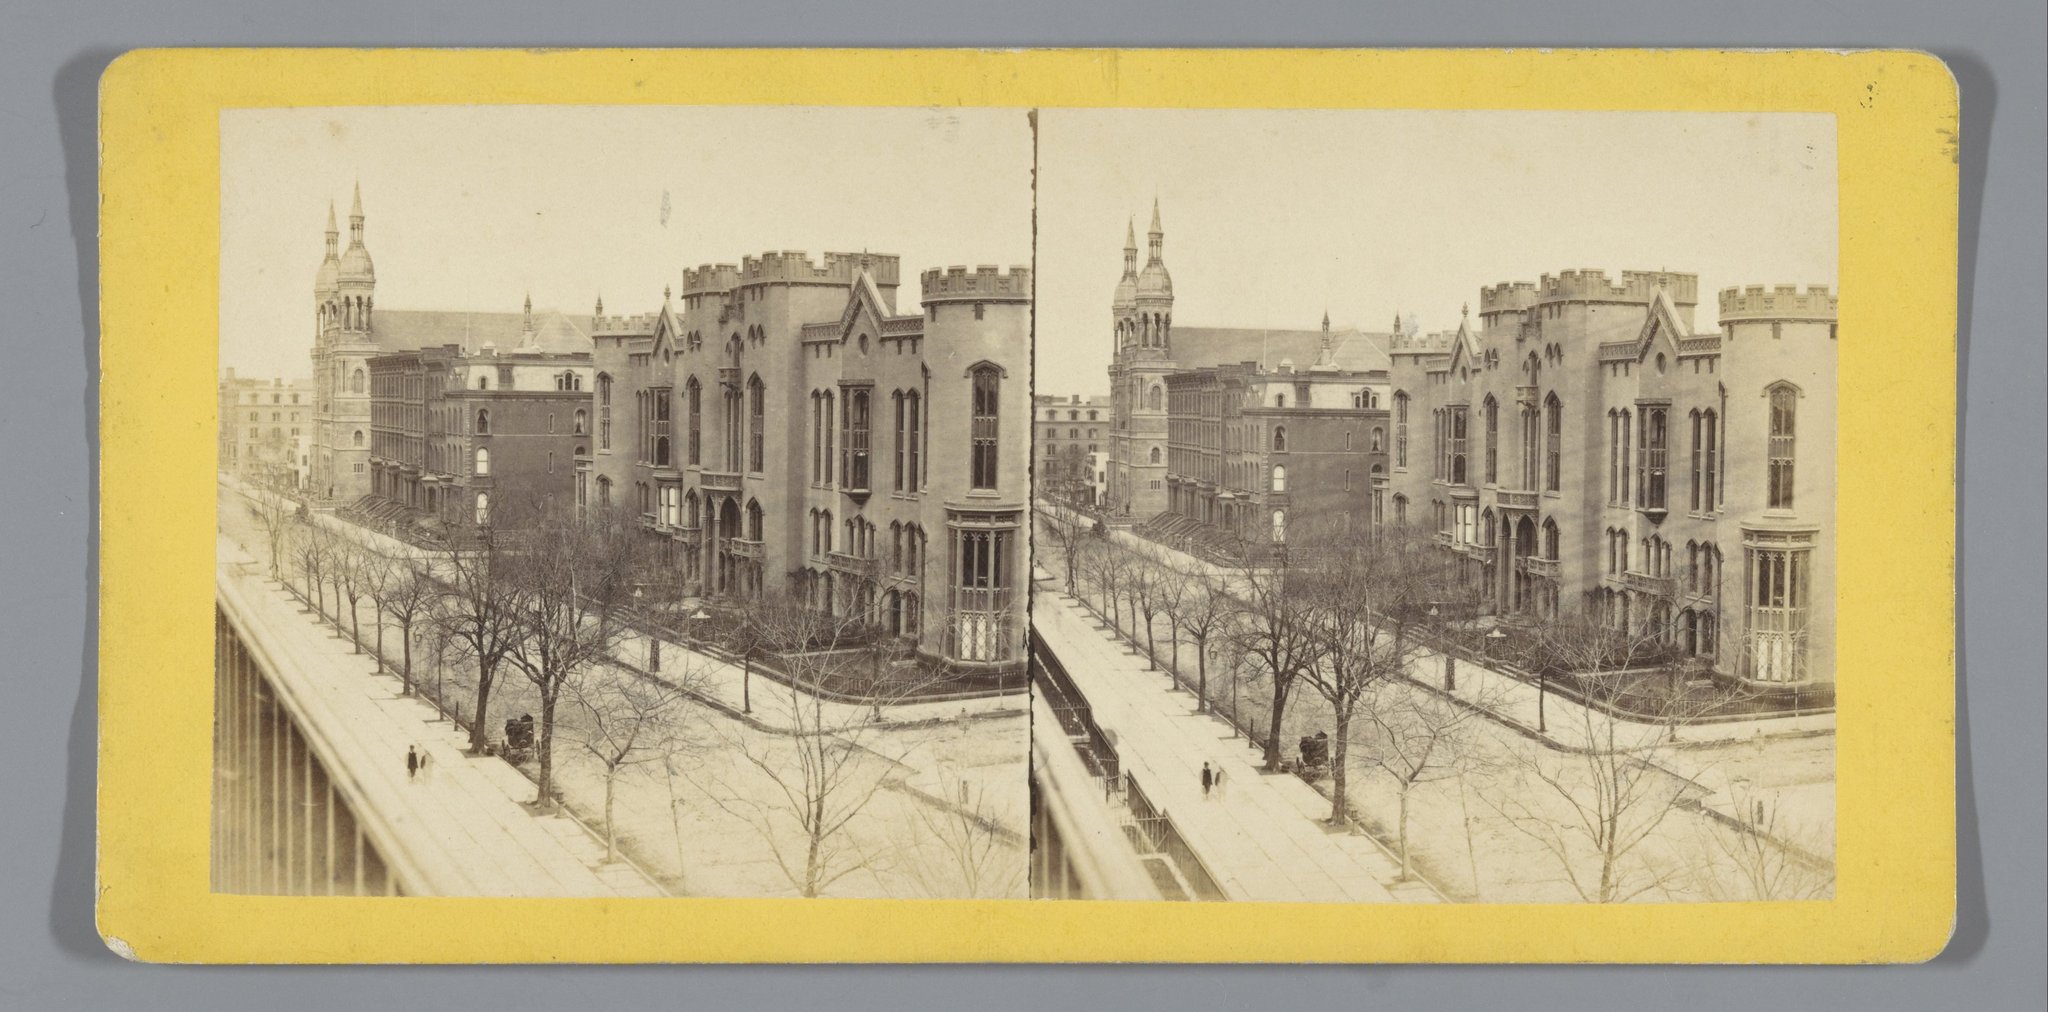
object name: stereograph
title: Fifth Avenue in New York, gezien vanaf het reservoir in Central Park richting het noorden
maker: Anonymous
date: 1871-1880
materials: cardboard, paper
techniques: albumen print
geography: new york city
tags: street, new york (city)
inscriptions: number: ‘No. 8047’, address: ‘Emporium of American and Foreign Stereoscopic Views, Chromos and Albums, 591 Broadway, opposite Metropolitan Hotel, New York.’